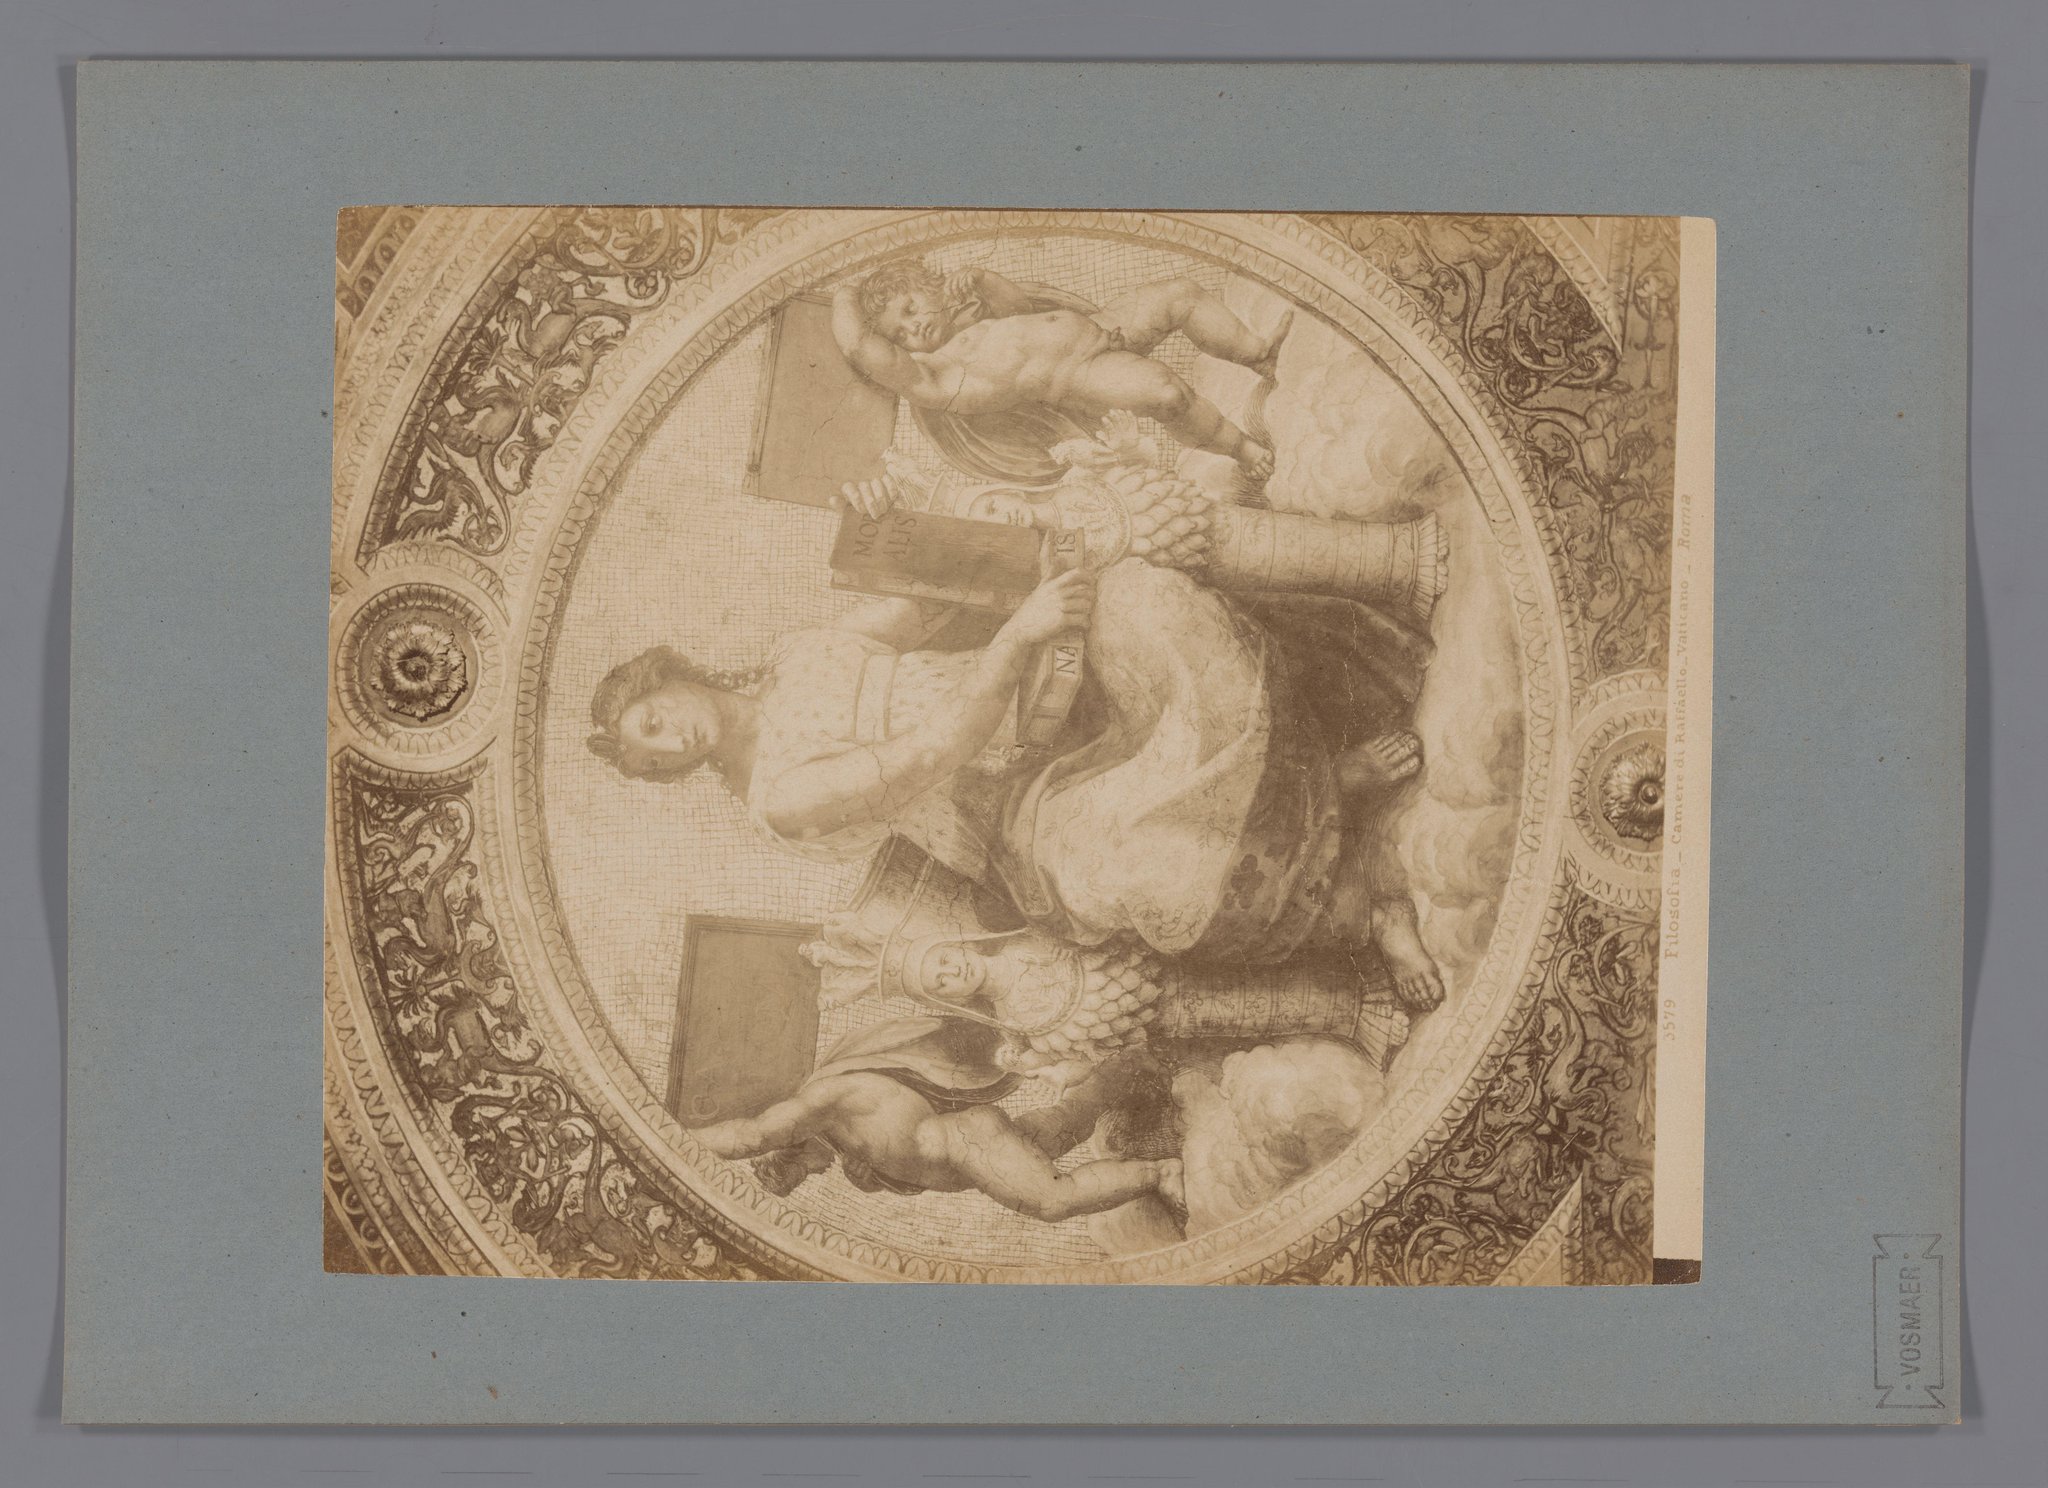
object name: photograph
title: Fotoreproductie van het fresco Filosofie door Rafaël in de Stanza della Segnatura, Vaticaanstad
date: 1851-1900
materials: cardboard, paper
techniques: albumen print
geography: vatican city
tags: picture, painting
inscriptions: number: ‘3579’, collector's mark: ‘VOSMAER’